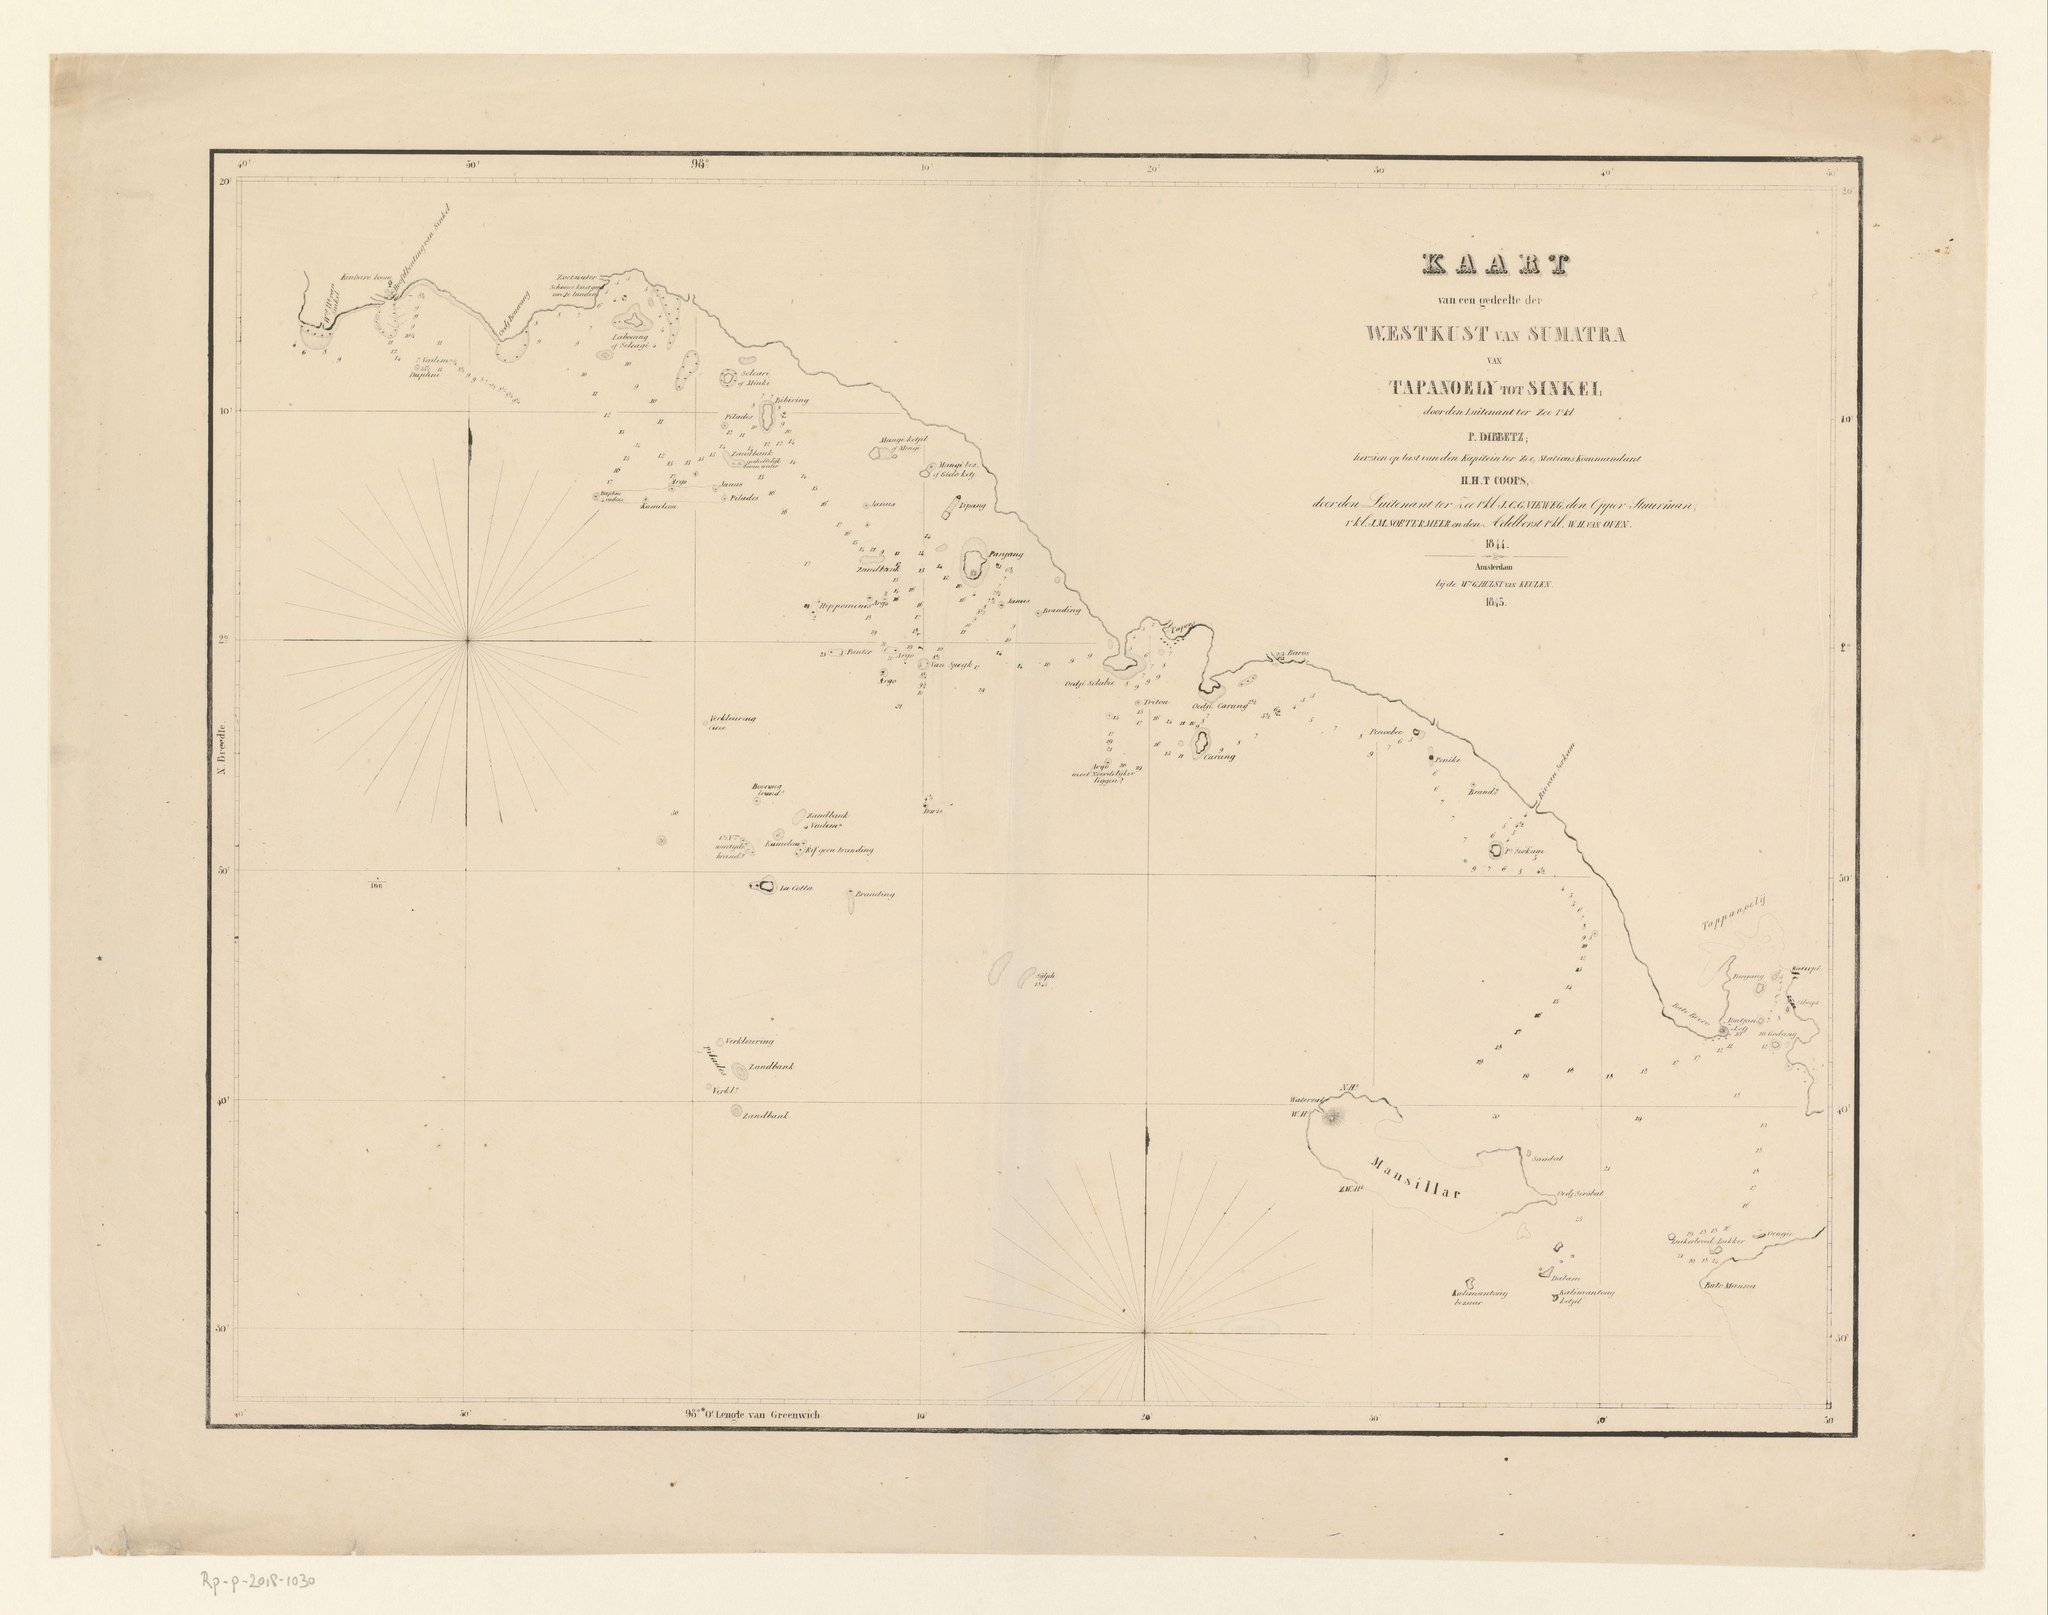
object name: print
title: Kaart van een gedeelte der westkust van Sumatra van Tapanoely tot Sinkel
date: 1845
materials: paper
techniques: lithograph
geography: amsterdam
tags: maps of separate countries or regions, sumatra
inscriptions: collector's mark: Lugt 2228